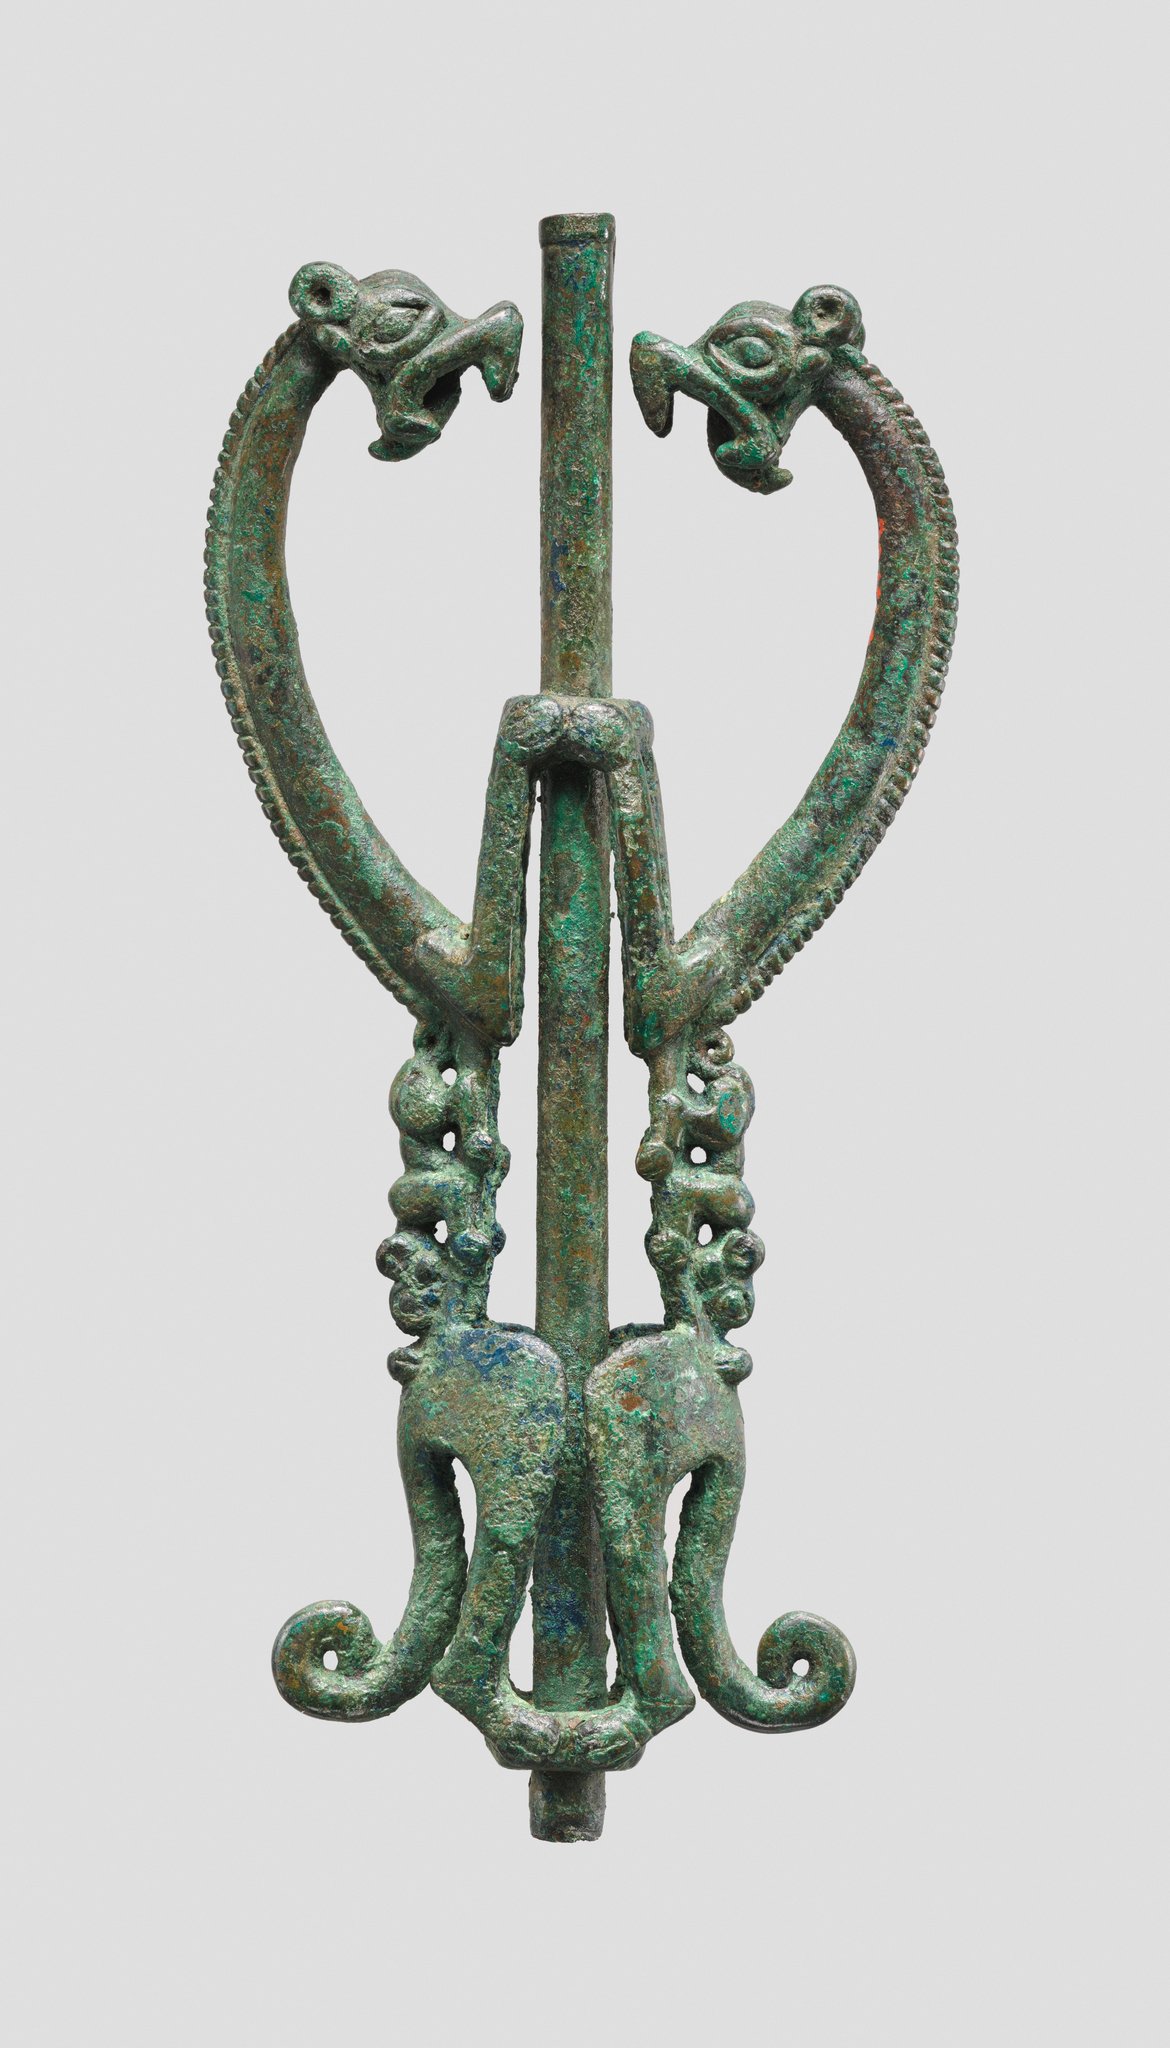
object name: standard top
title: Top for standard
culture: iranian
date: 800-601 BCE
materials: bronze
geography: iran, probably from luristan